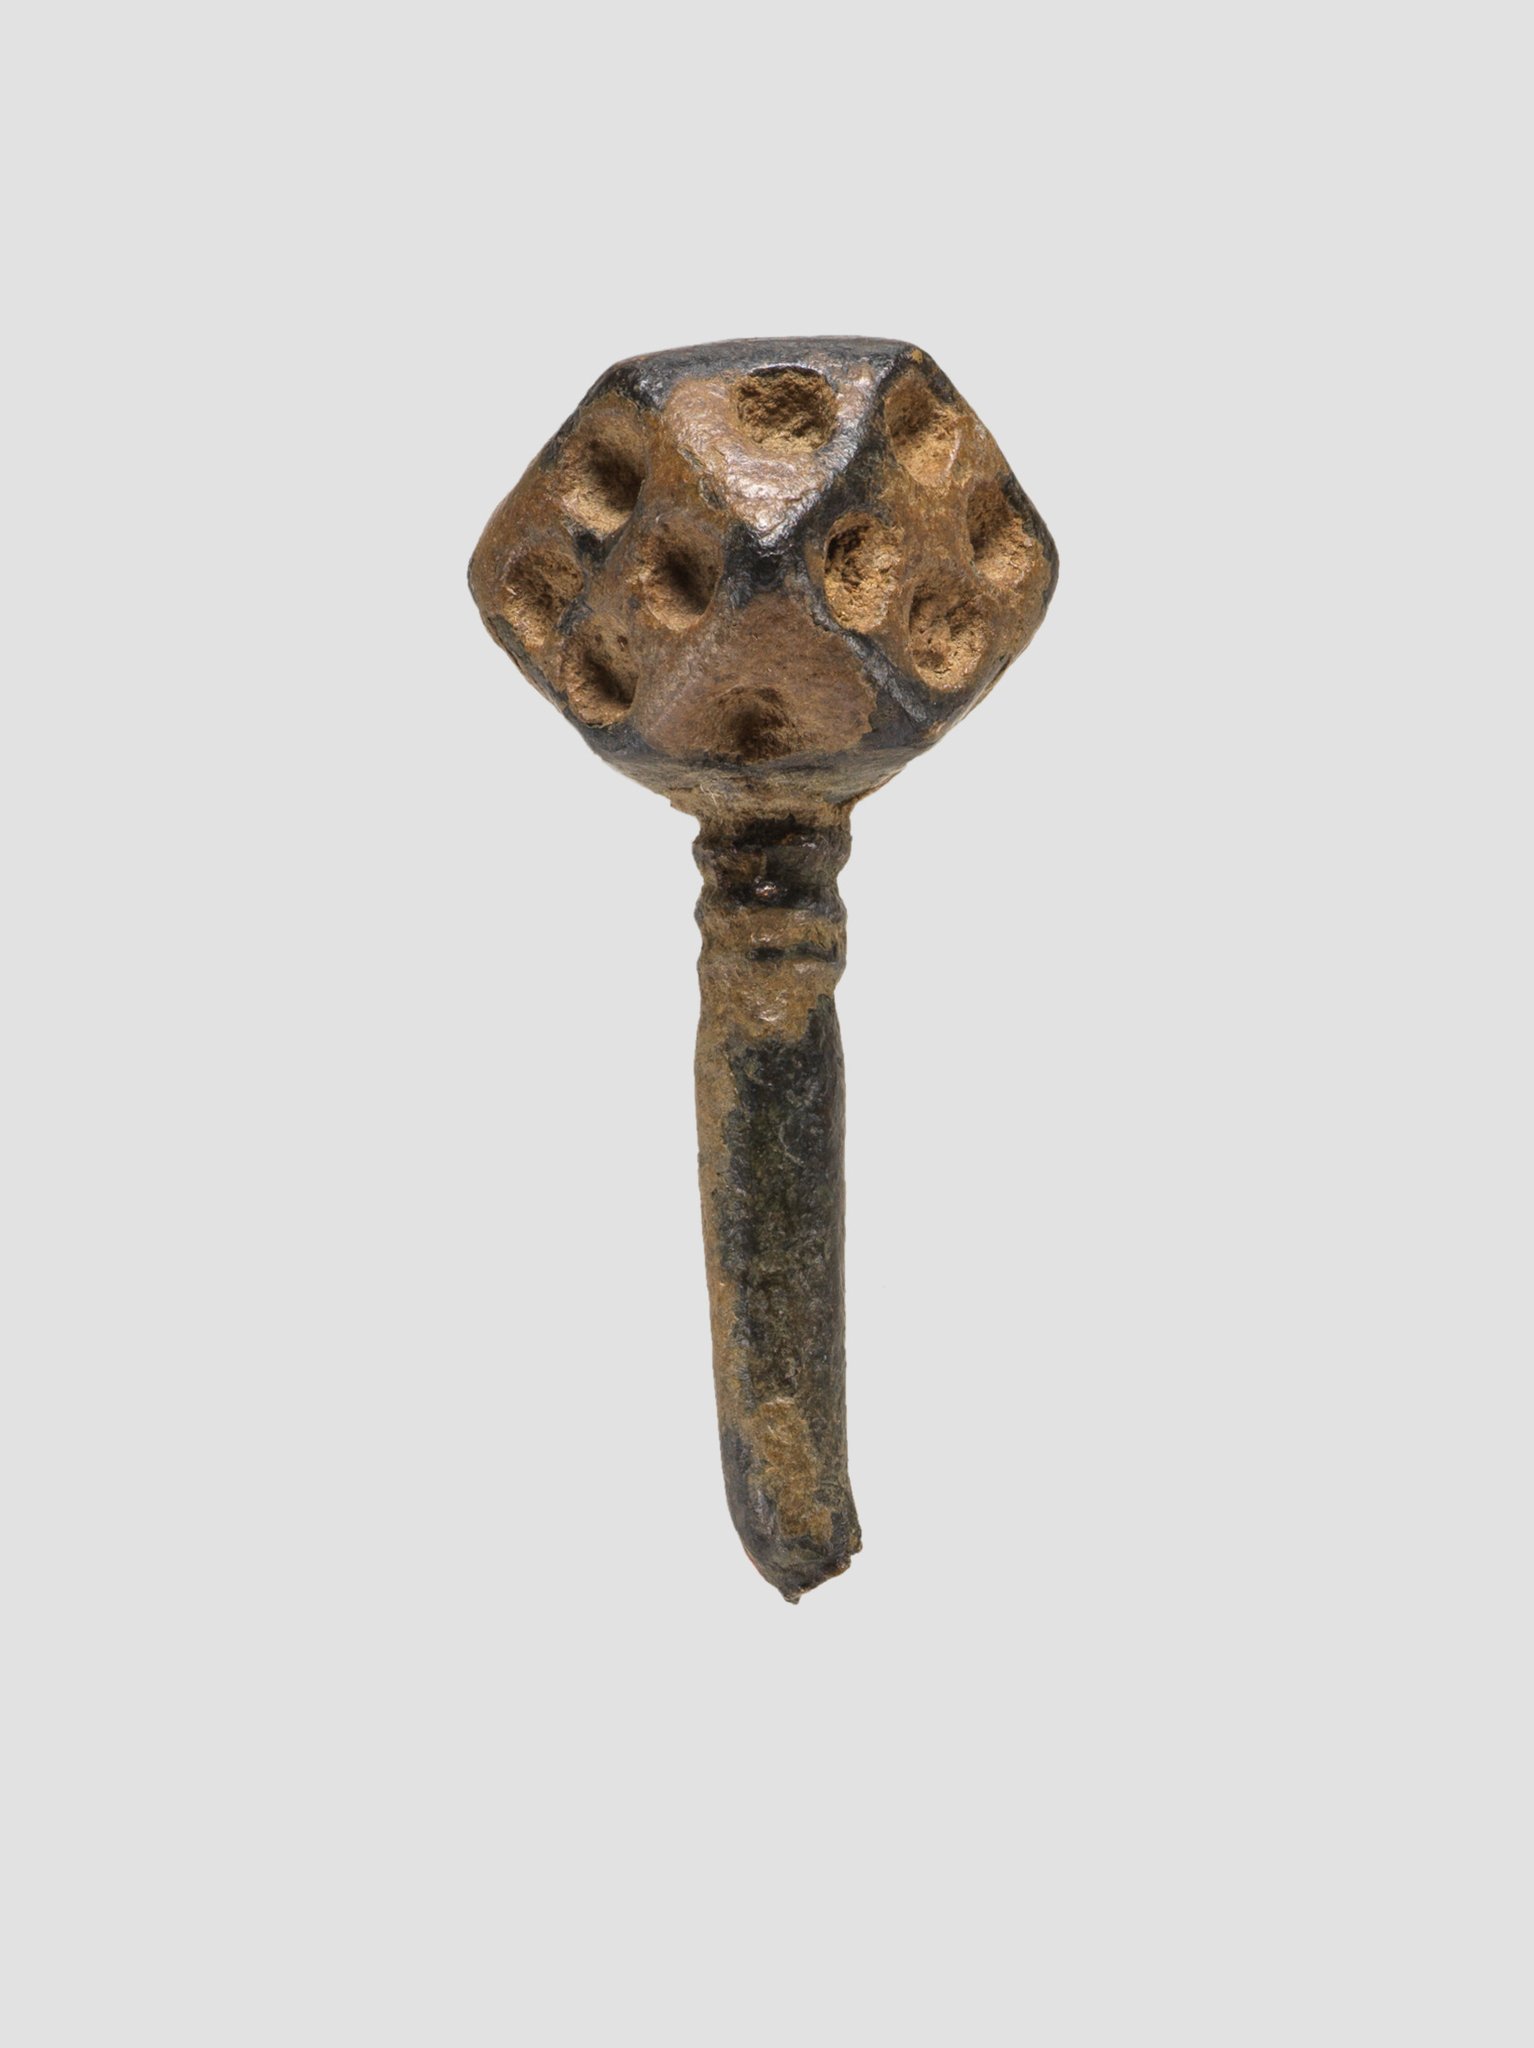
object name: pin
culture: iranian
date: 800-601 BCE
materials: bronze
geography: iran, luristan